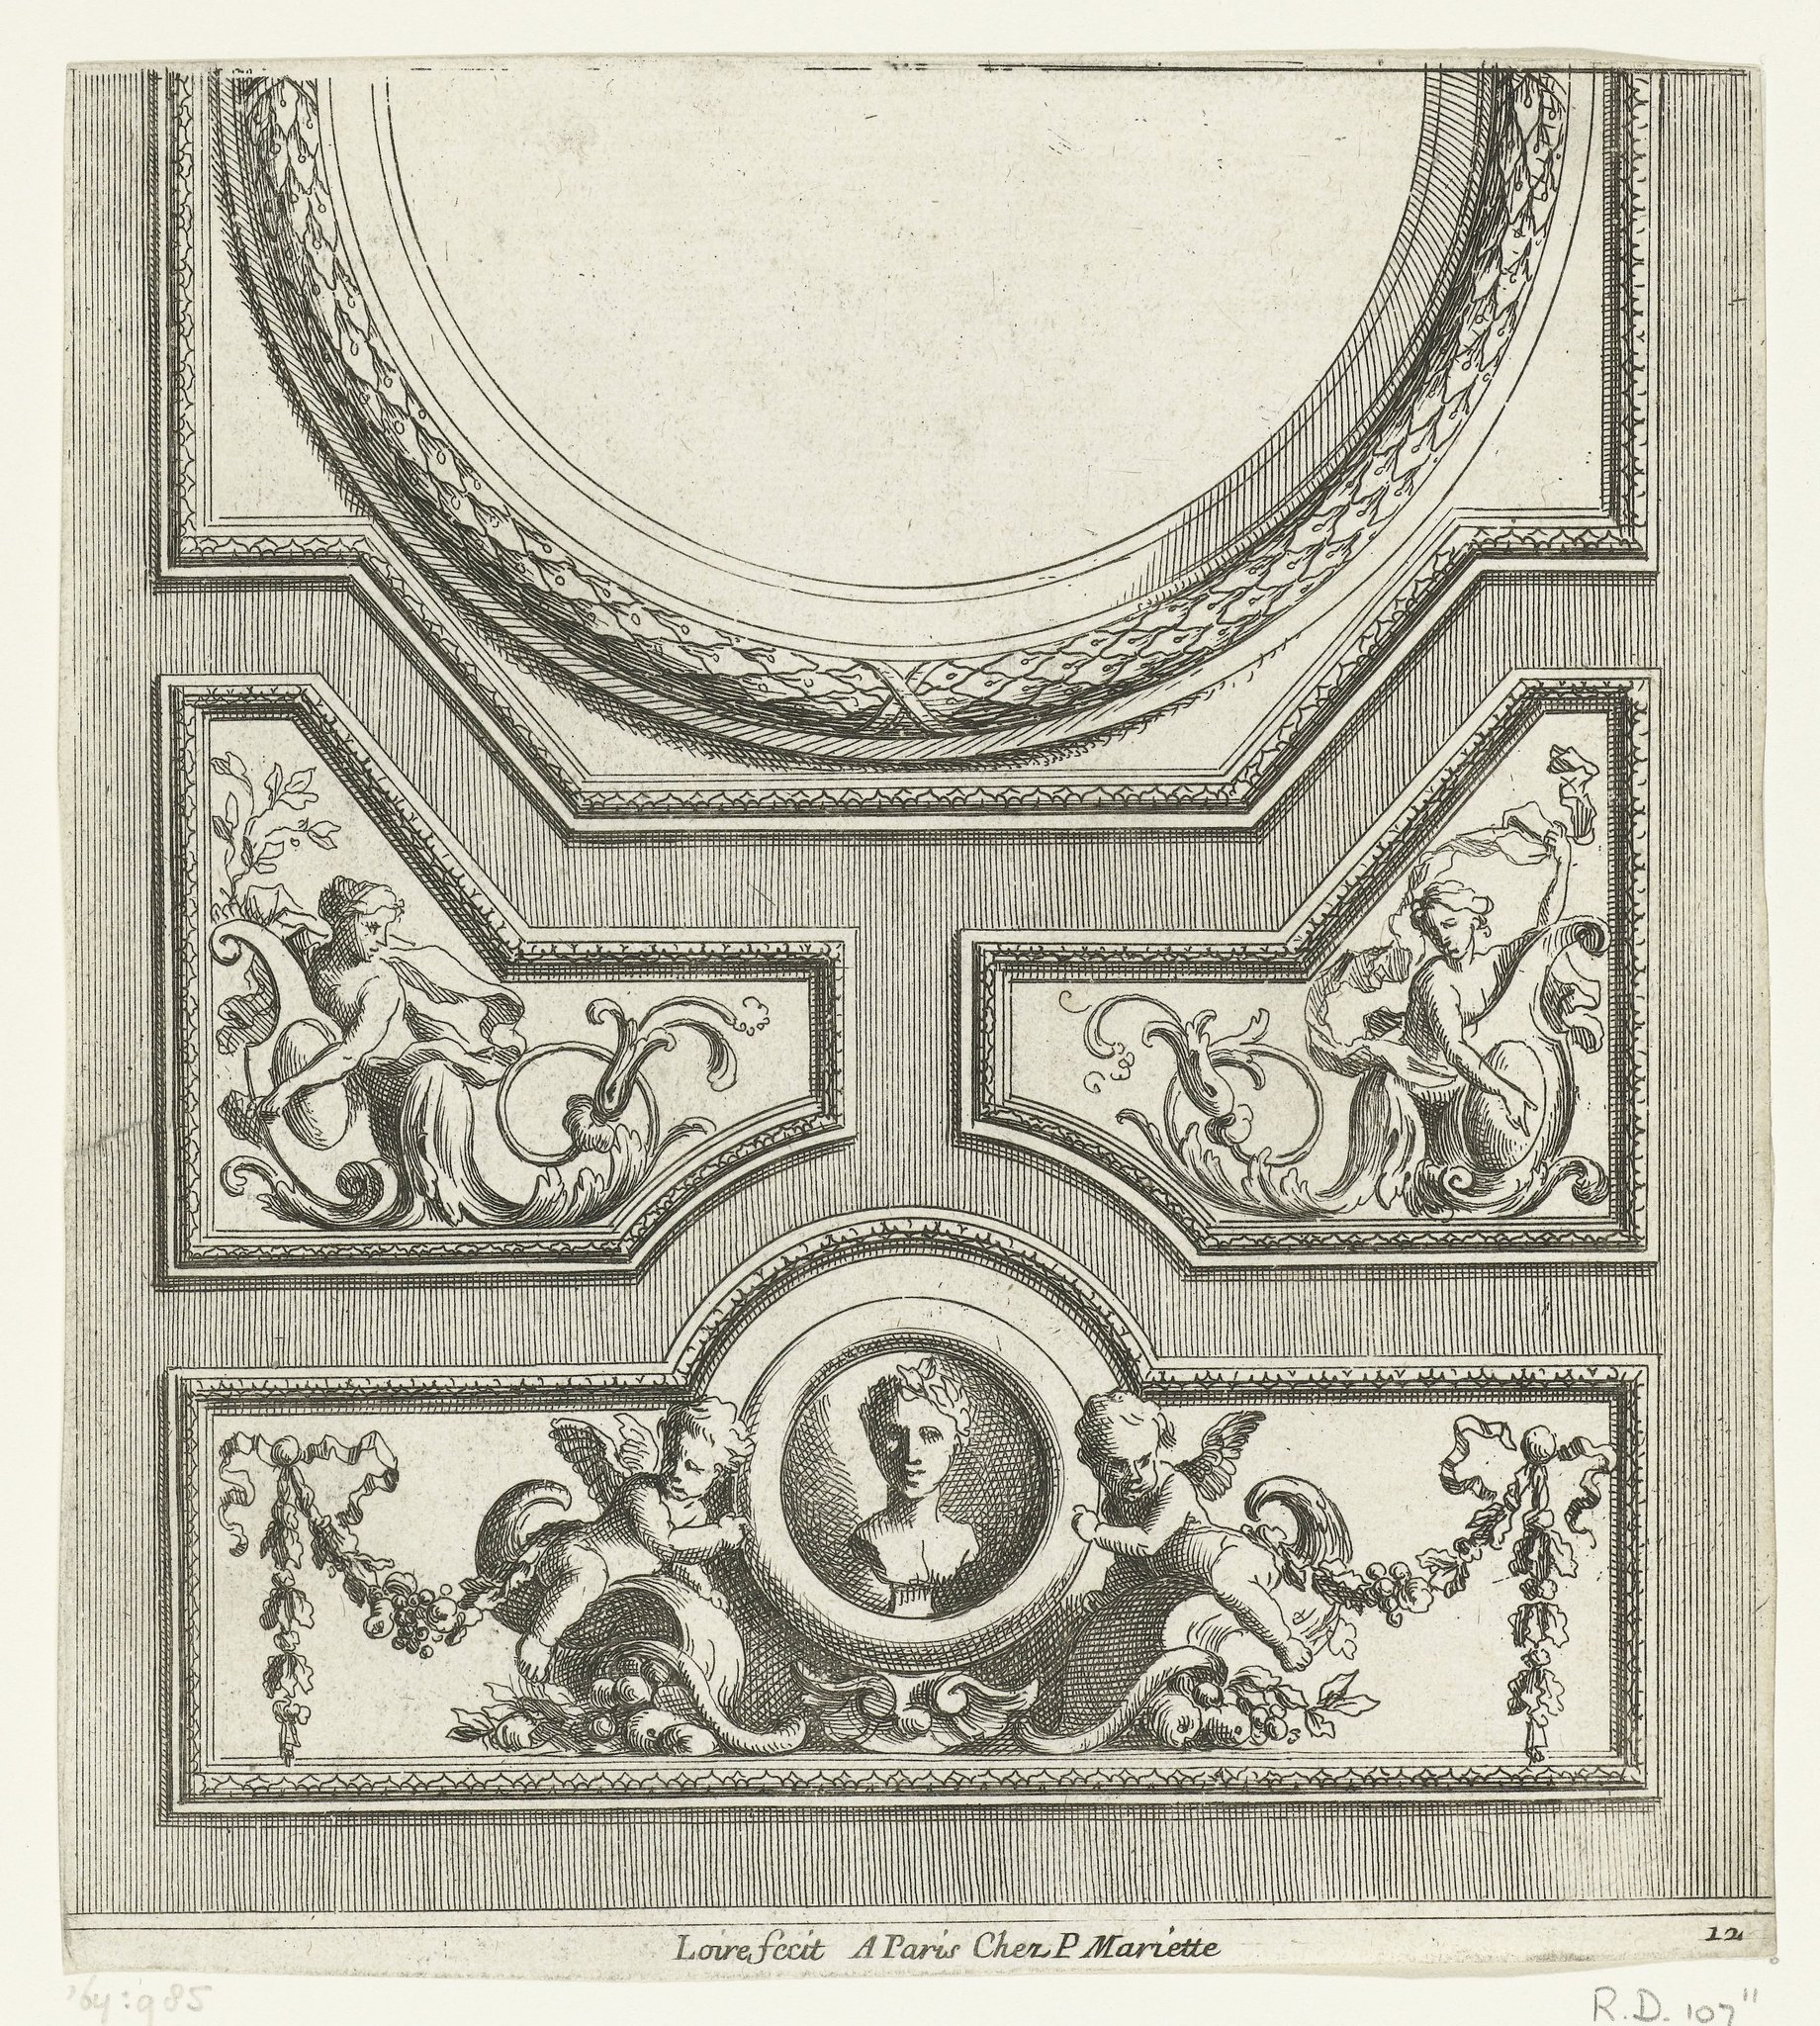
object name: ornament print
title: Plafonds à la moderne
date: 1634-1716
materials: paper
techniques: etching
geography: france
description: In het midden een leeg medaillon, daarnaast drie vlakken, het onderste met een portetmedaillon. Uit tweede editie.